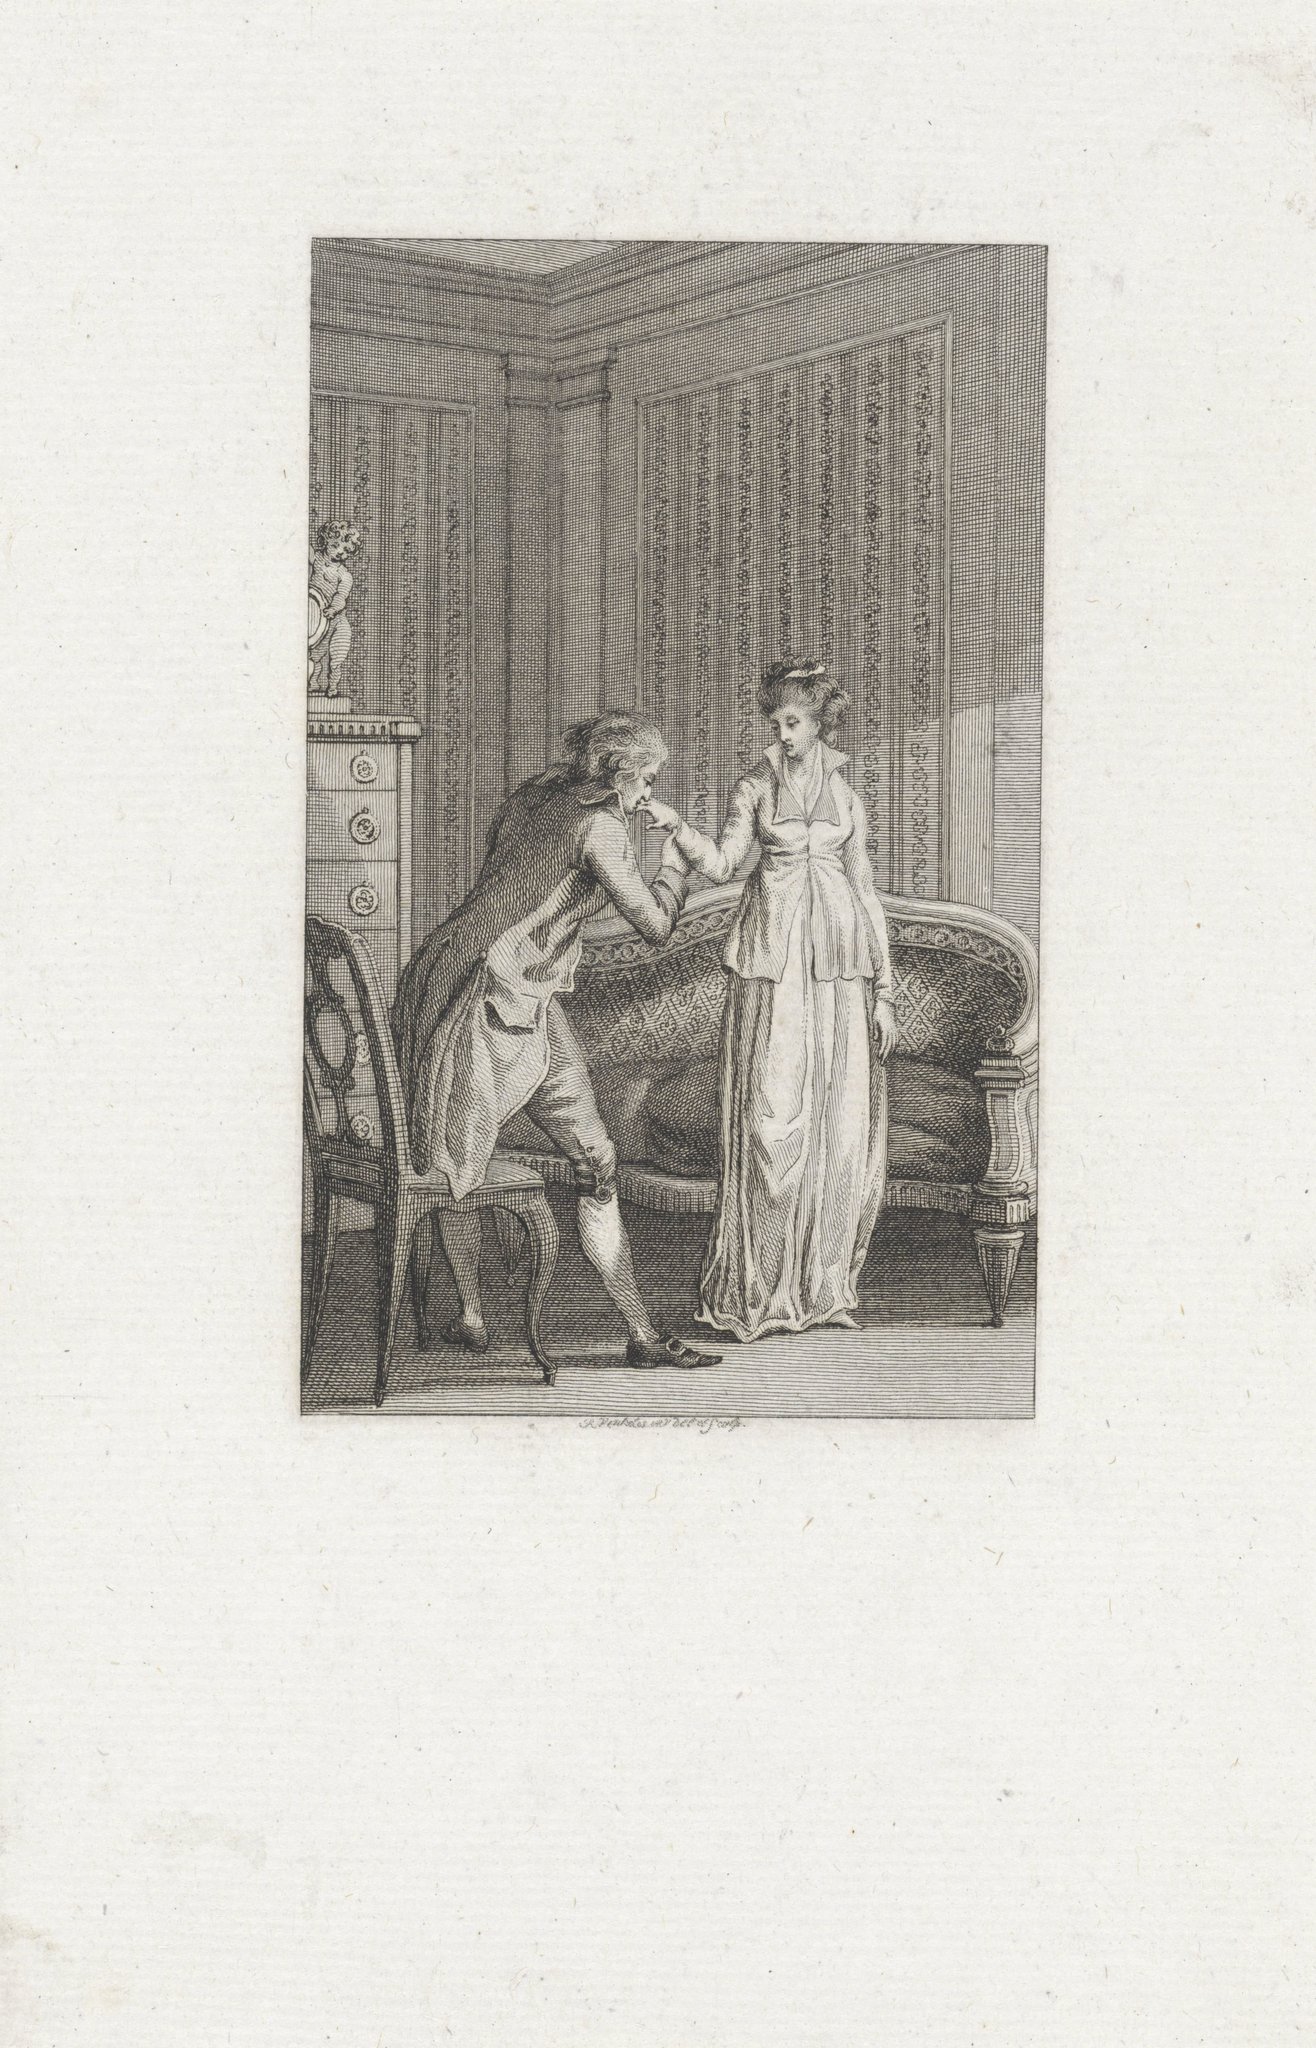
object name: print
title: Heer die de hand van een dame kust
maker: reinier vinkeles (i)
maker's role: draughtsman, print maker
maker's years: 1741-1816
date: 1801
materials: paper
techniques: engraving, etching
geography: amsterdam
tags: chair, kissing the hand (lovers), couch, sofa, settee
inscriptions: collector's mark: Lugt 240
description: Illustratie uit: Richardson, Samuel. Geschiedenis van Clarissa Harlowe. Deel 3. Amsterdam: Johannes Allart, 1797-1805.